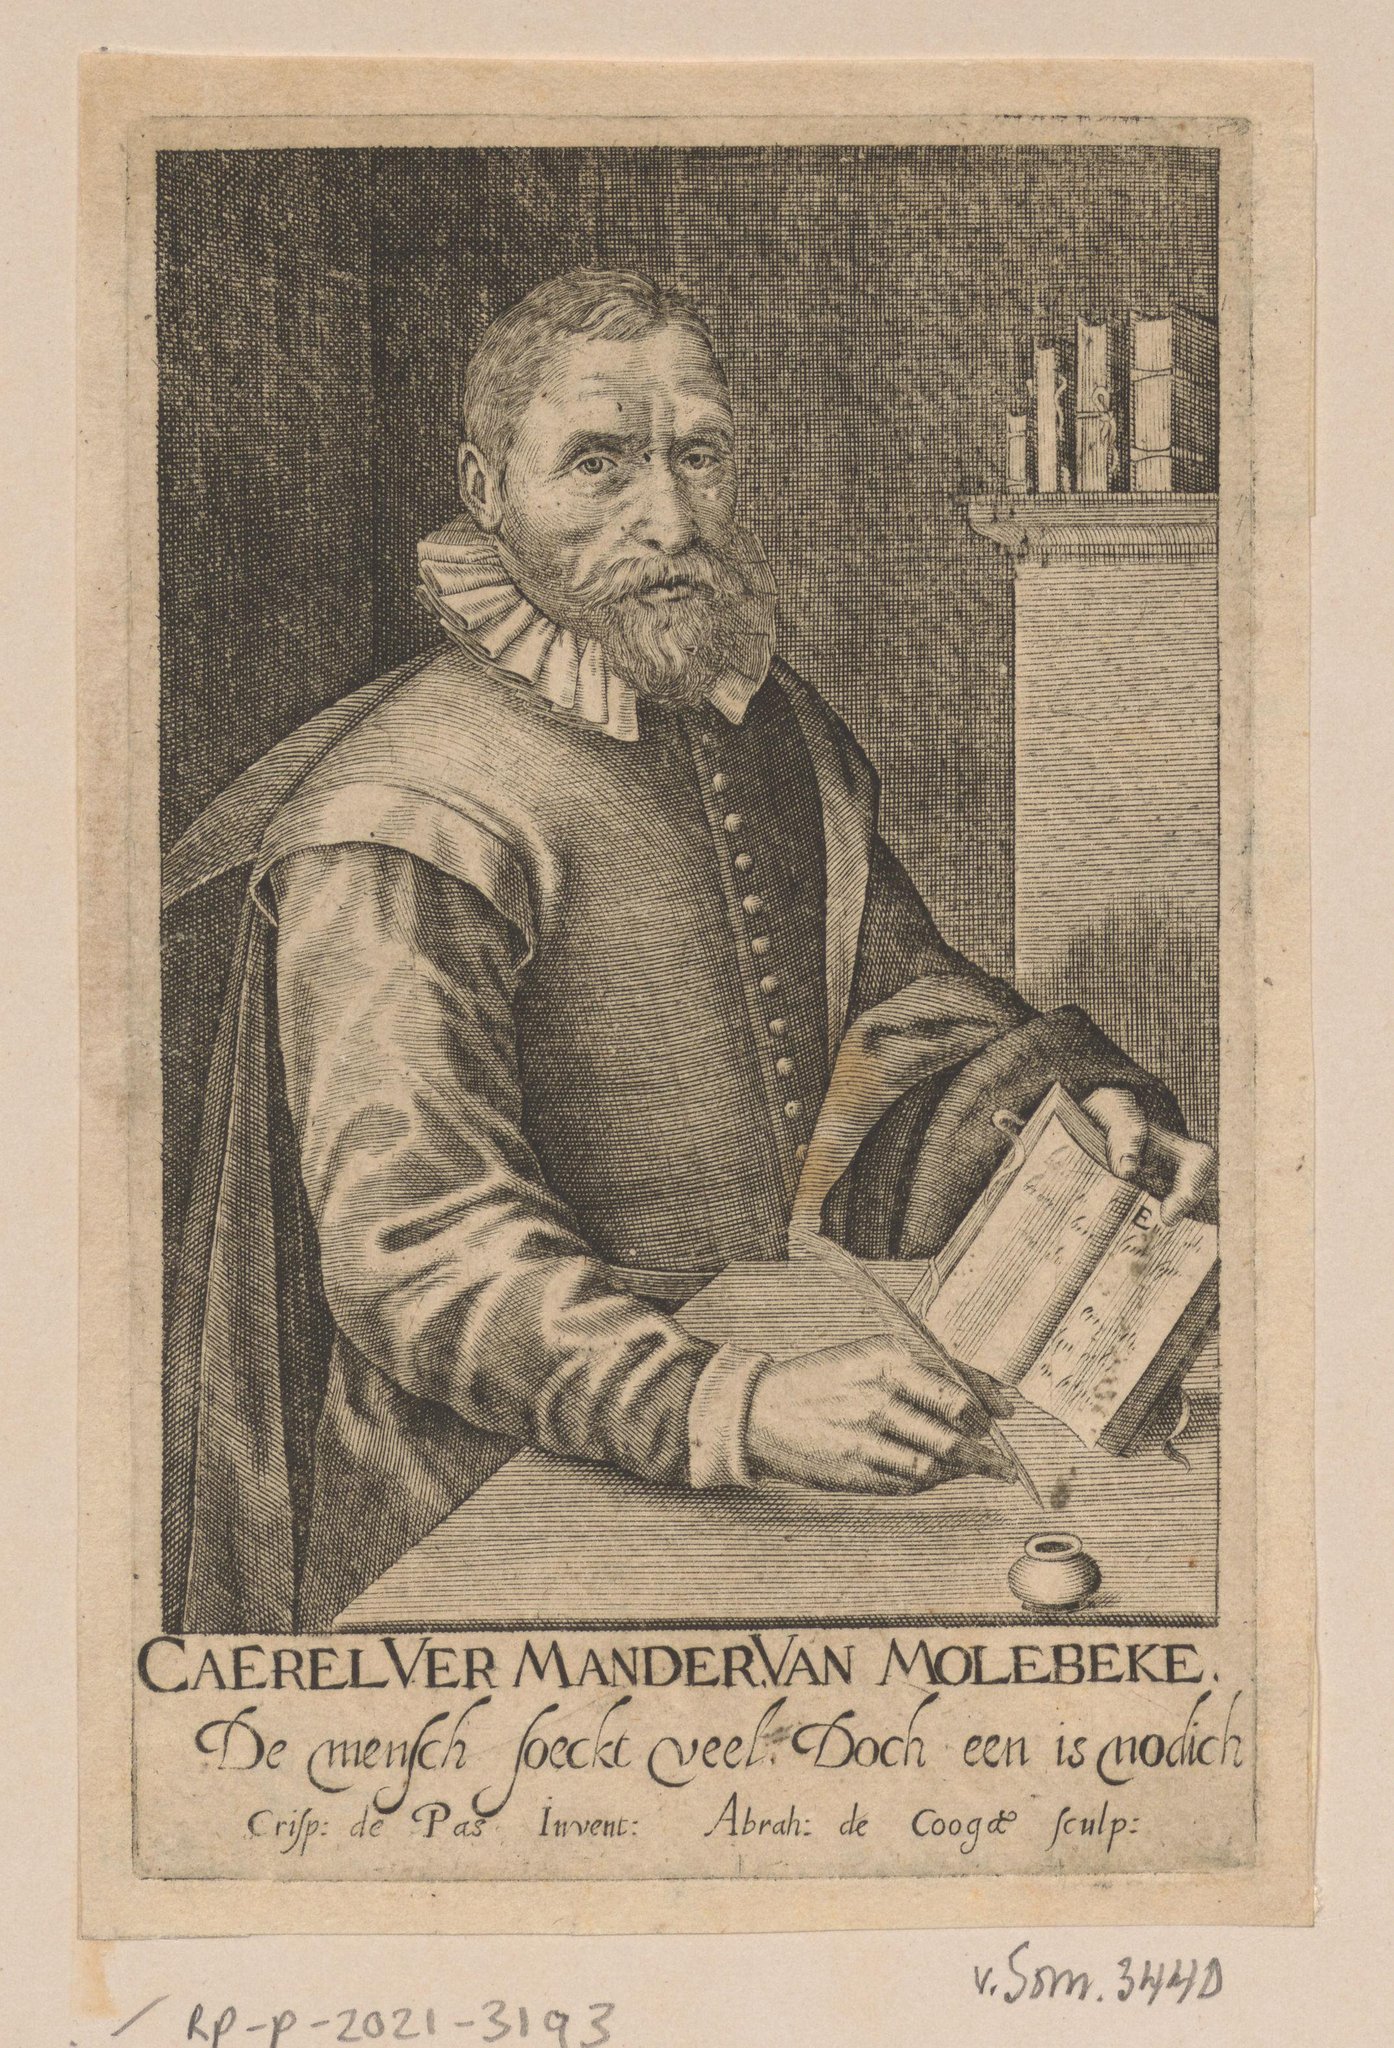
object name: print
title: Portret van Karel van Mander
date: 1620-1686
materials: paper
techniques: engraving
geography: haarlem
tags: amsterdam, painter, print maker, karel van mander (i), handwriting, writing as activity, historical persons, portrait of a writer, portrait, self-portrait of painter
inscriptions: number: ‘41’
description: Met onder het portret het motto 'Mensch soeckt veel, doch een is noodich'.